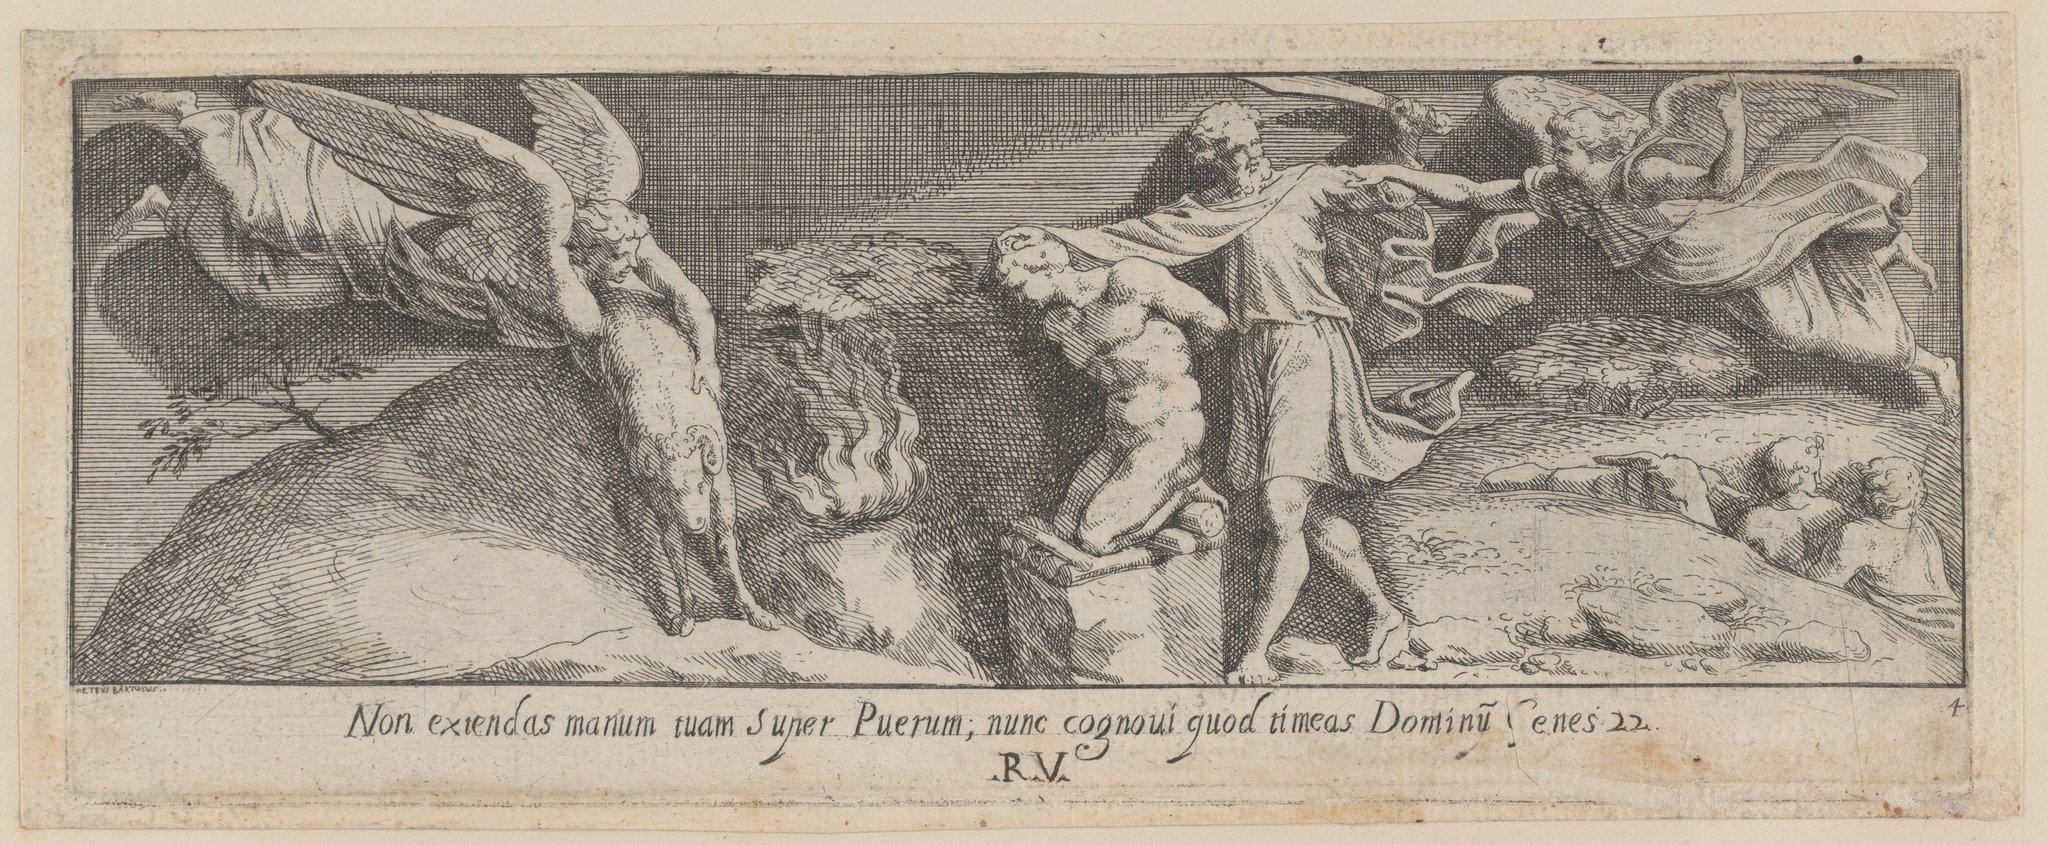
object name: print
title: Plate 4: The Sacrifice of Abraham, from Genesis Chapter 22, after a lost fresco in the basamento of Bay 4 of the Vatican Loggia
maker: pietro santi bartoli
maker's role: artist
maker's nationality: italian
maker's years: 1615-1700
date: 1650-1677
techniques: etching